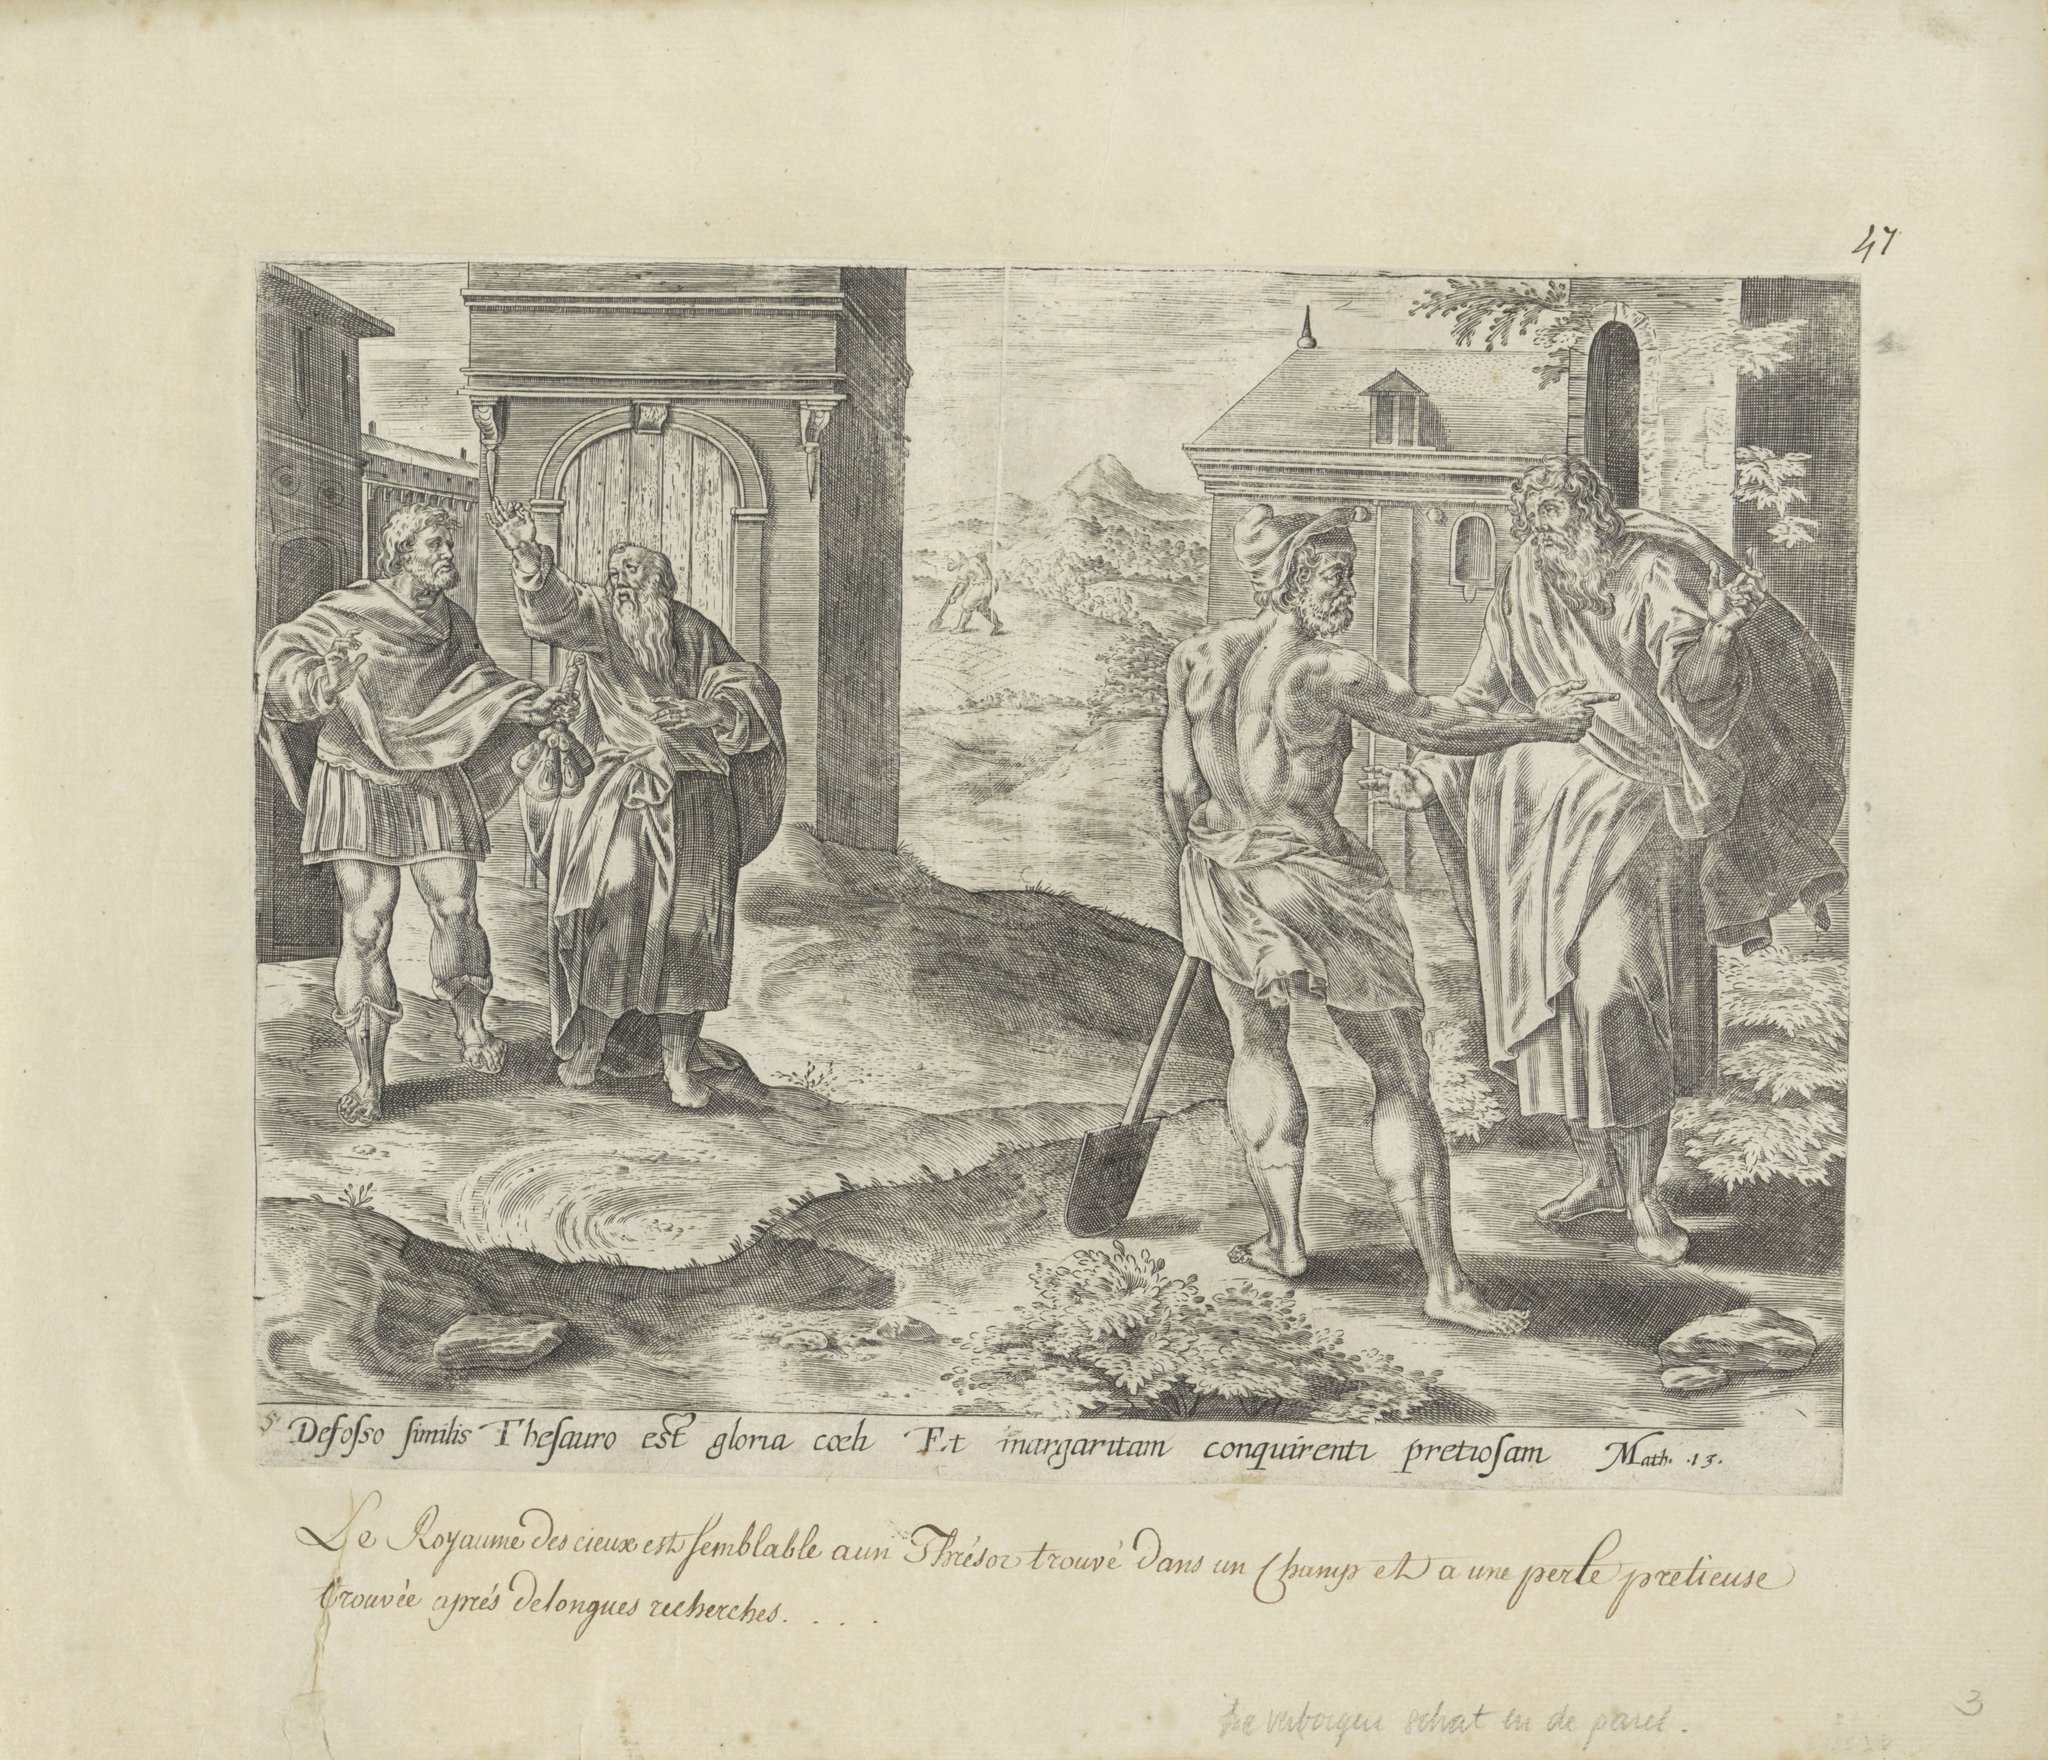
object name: print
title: Gelijkenissen uit het Nieuwe Testament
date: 1585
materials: paper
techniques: engraving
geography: antwerp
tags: 'the kingdom of heaven is like treasure hidden in a field' ~ proverbial saying of christ (matthew 13:44)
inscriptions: inscription: ‘Le royaume des cieux est semblable a un Thésor trouvé dans un champ et a une perle pretieuse trouvée aprés delongues recherches ...’, collector's mark: Lugt 2228, number: ‘47’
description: Een man koopt nadat hij in een akker een schat heeft gevonden de akker van de eigenaar. Op de achtergrond is te zien hoe de man de schat vindt en weer begraaft. Op de voorgrond staat de man met een stokkenbeurs in de hand om te onderhandelen en de akker te kopen. Onder de voorstelling een verwijzing in het Latijn naar de Bijbeltekst in Mat. 13.